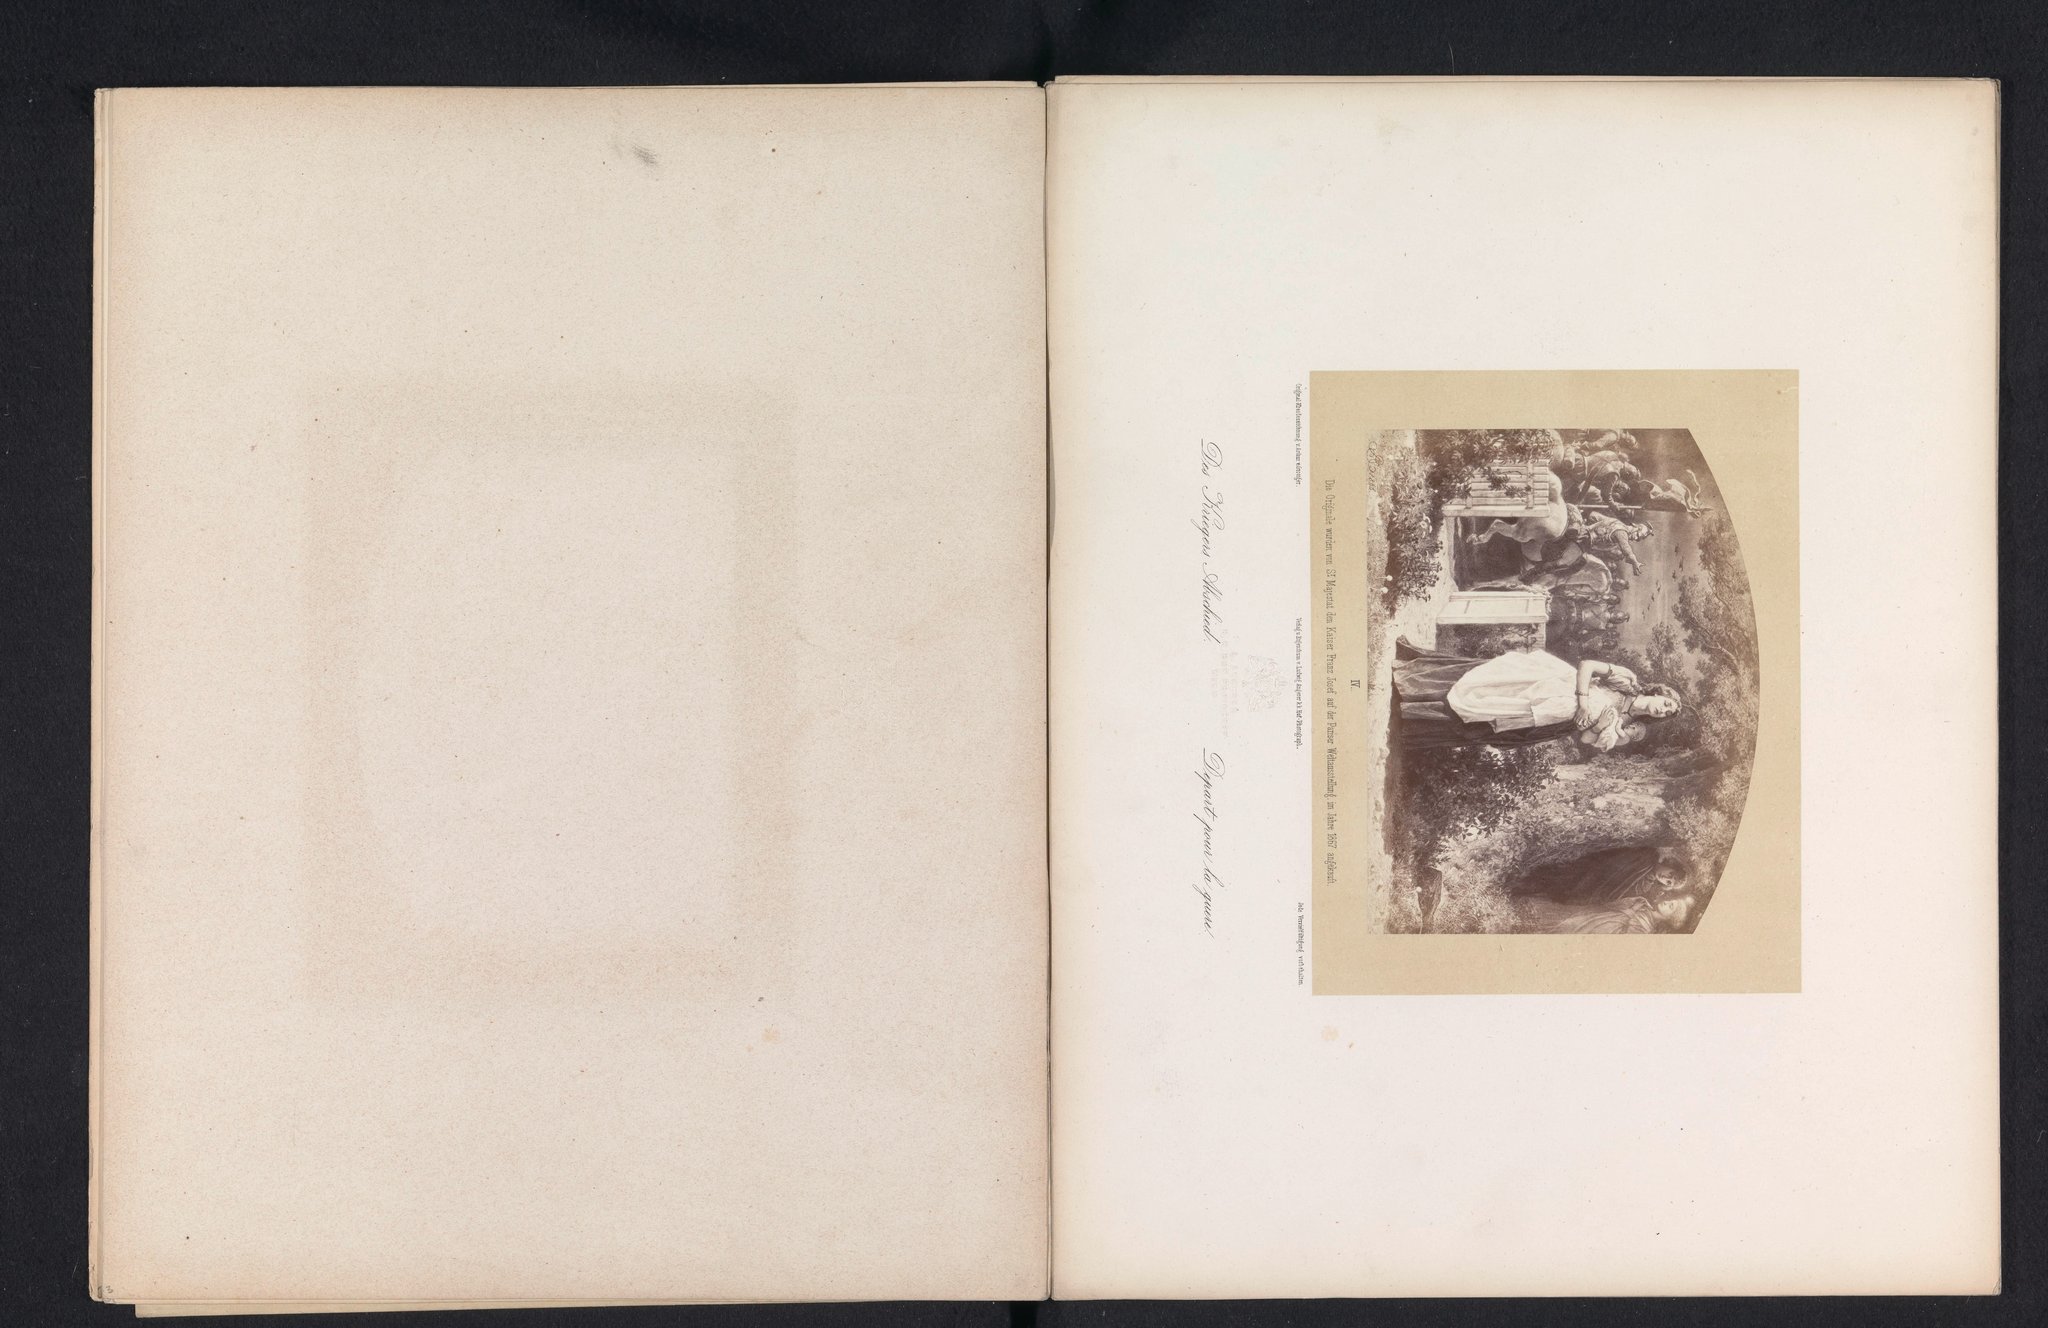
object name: page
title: Des Kriegers Abschied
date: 1867-1868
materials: photographic support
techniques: albumen print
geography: vienna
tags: the soldier; the soldier's life, waving farewell ~ departure on a journey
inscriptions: inscription: ‘Die Originale wurden von Sr Majestat den Kaiser Franz Josef auf der Pariser Weltausstellung im Jahre 1867 angekauft.’, number: ‘IV.’